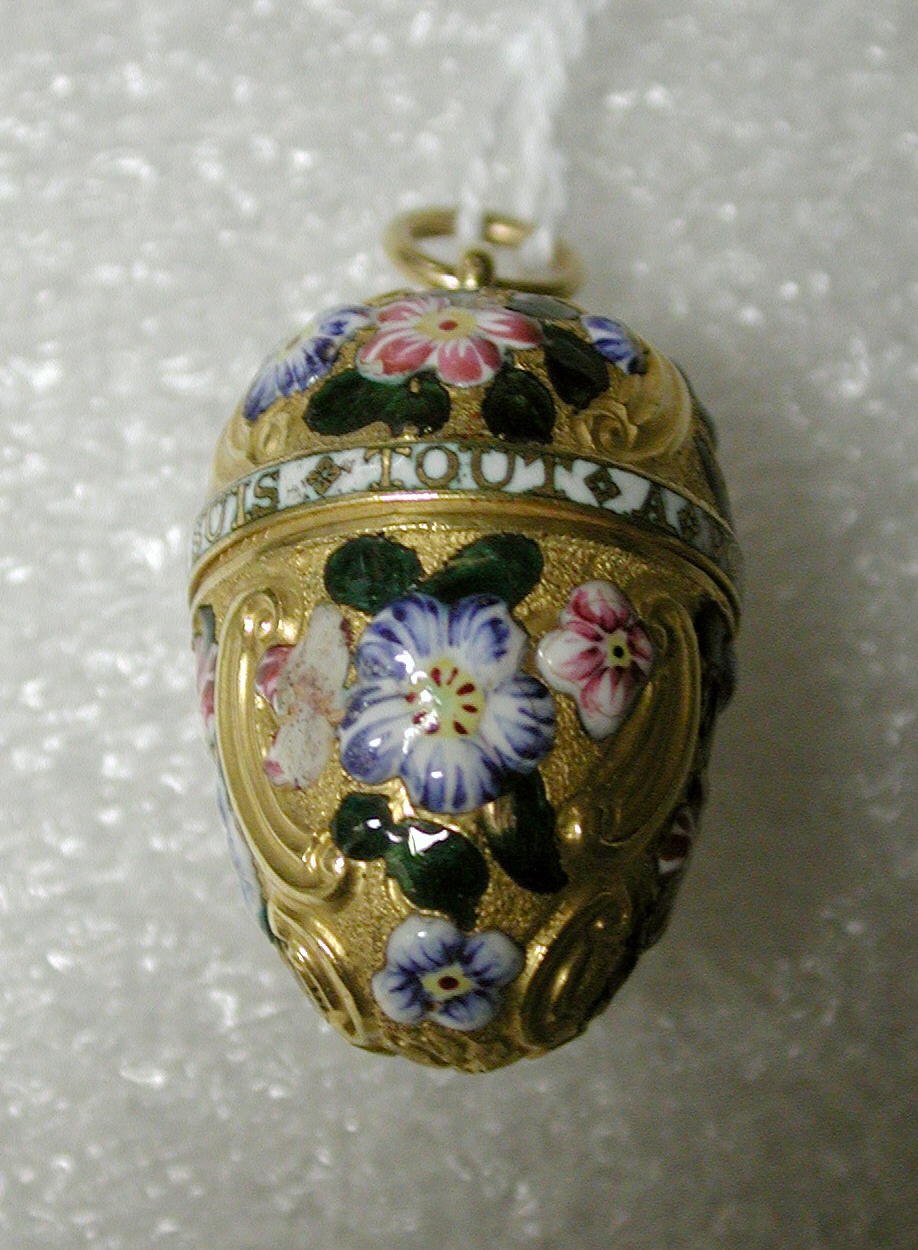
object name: vinaigrette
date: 1755-1760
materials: enamel, gold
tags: flowers